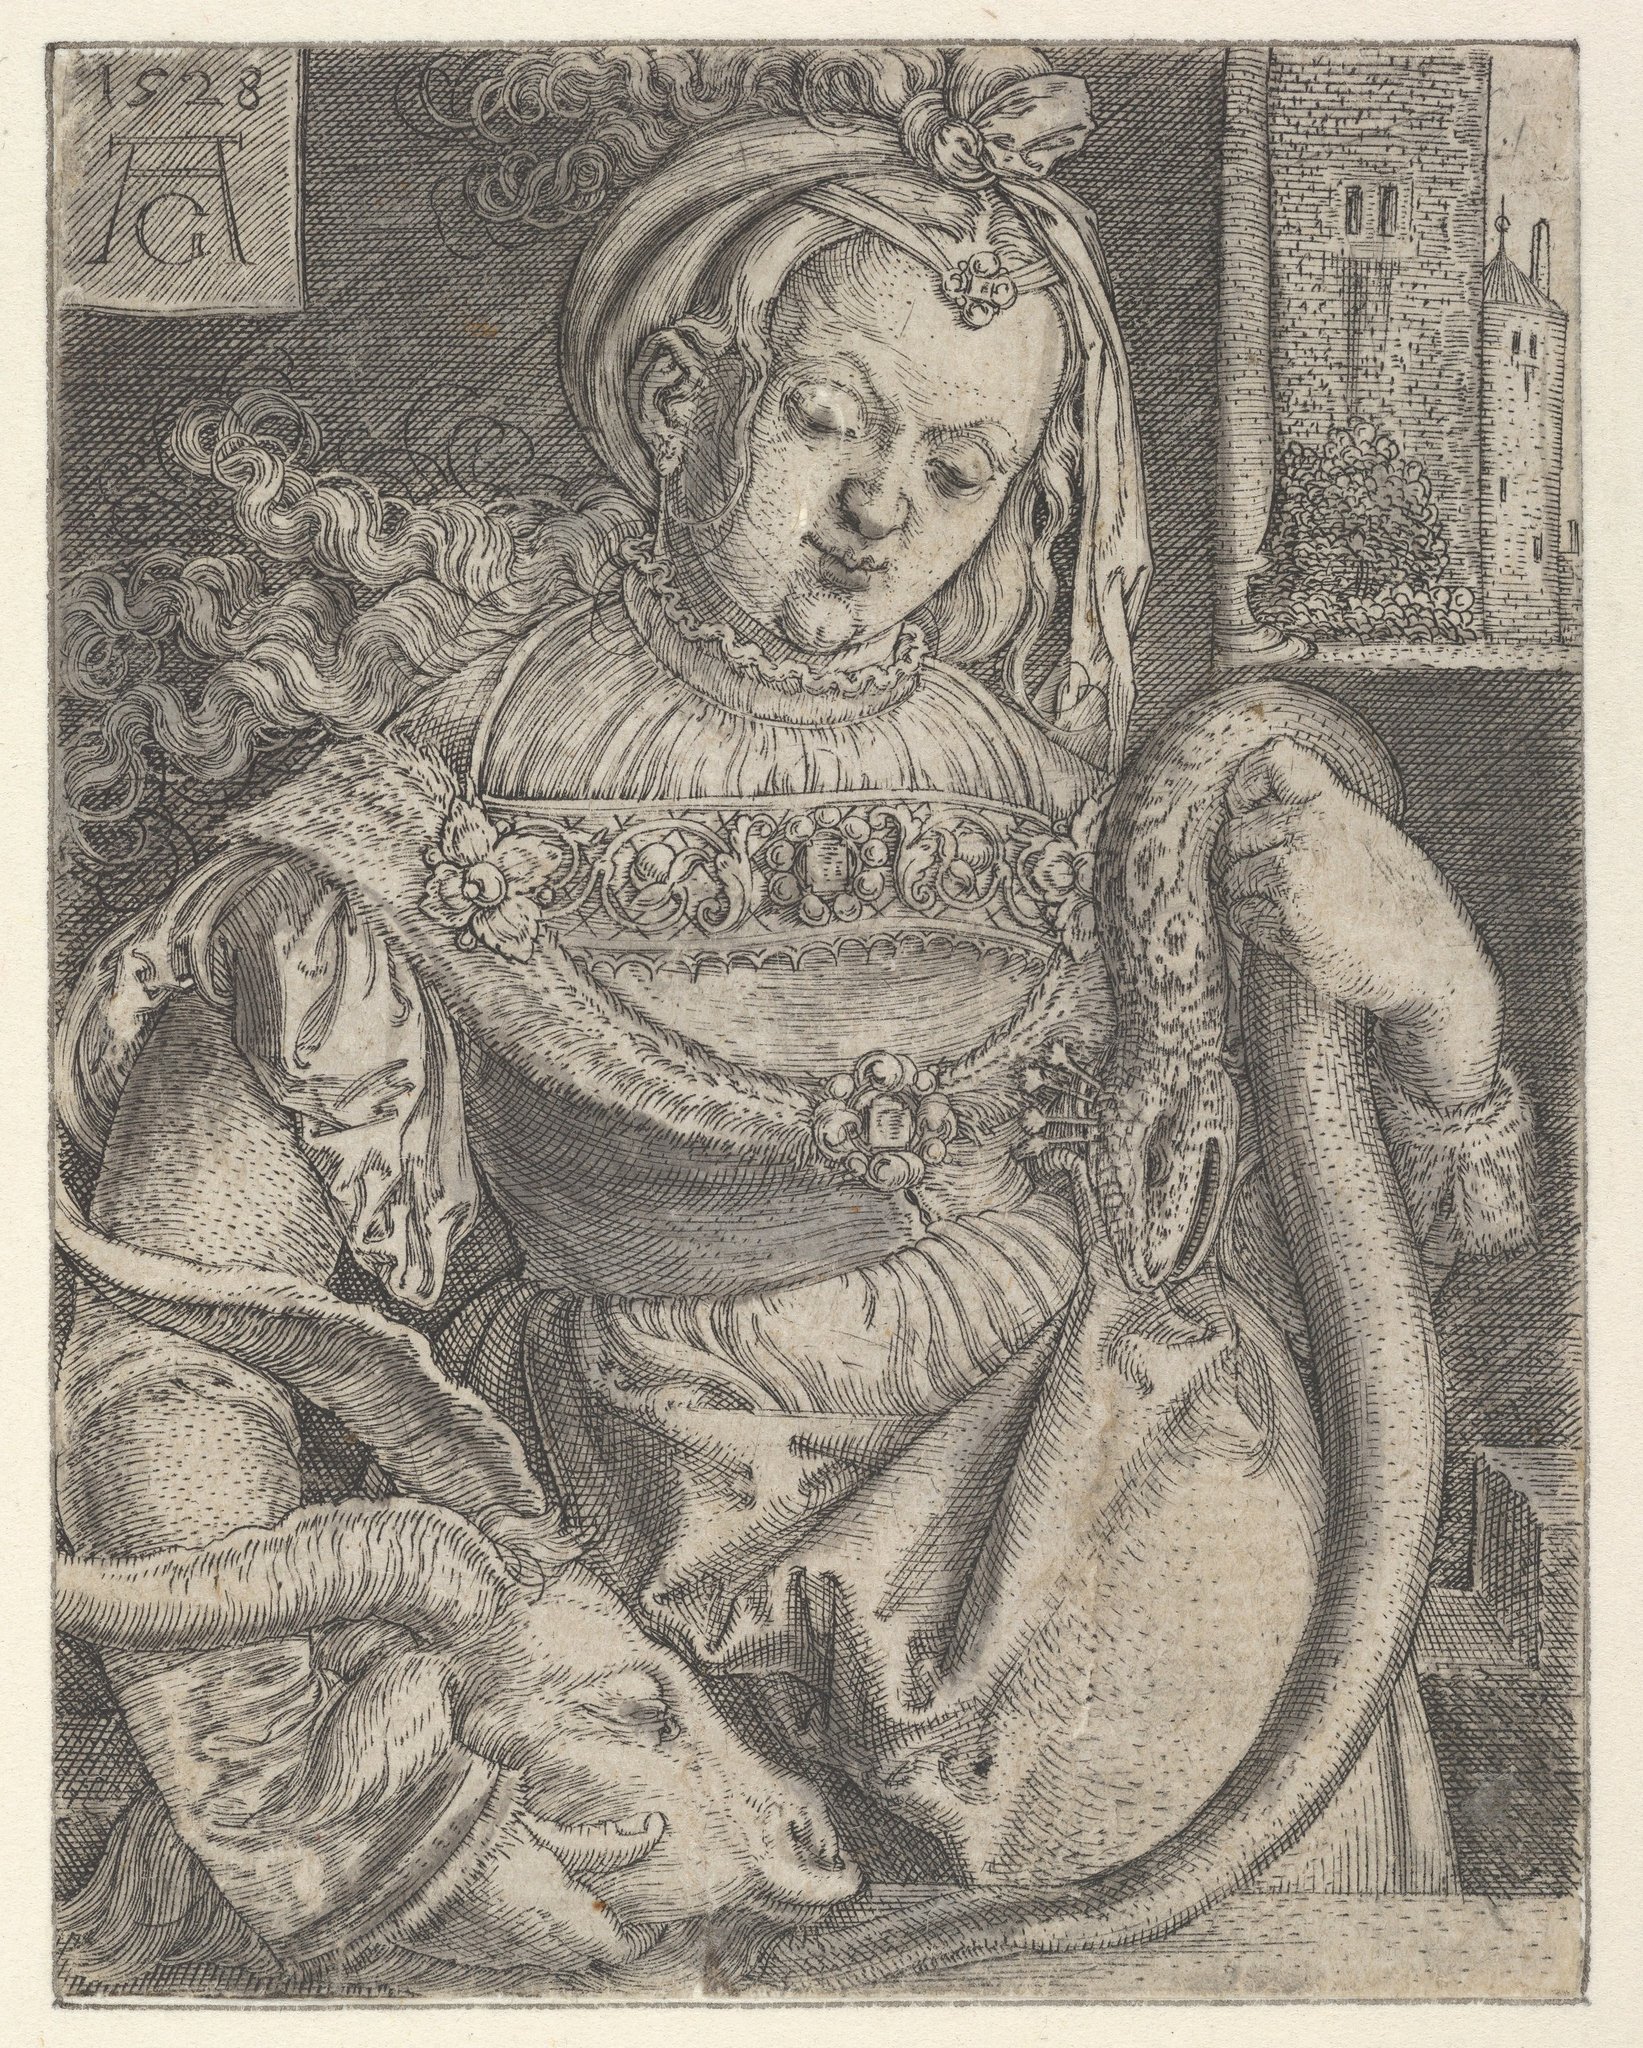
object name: print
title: Intemperance, from Vice and Virtues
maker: heinrich aldegrever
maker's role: artist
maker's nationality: german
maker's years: 1502-1561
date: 1528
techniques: engraving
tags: animals,women,serpents